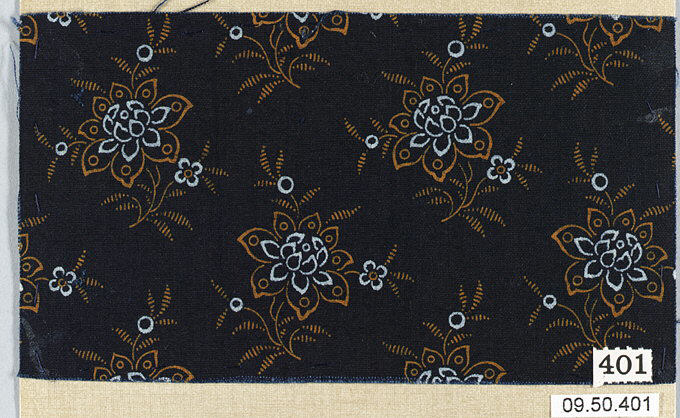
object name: piece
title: Piece (one of 116)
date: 1801-1900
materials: cotton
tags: flowers,leaves